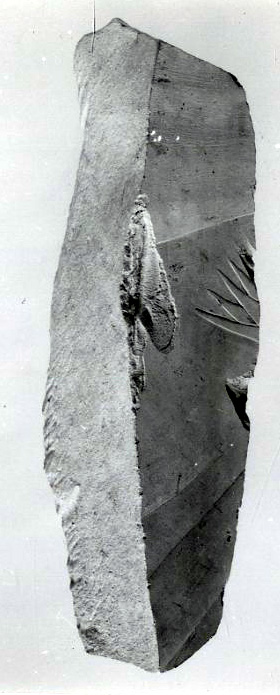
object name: relief fragment, tomb of meketre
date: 1981-1975 BCE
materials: limestone, paint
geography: egypt